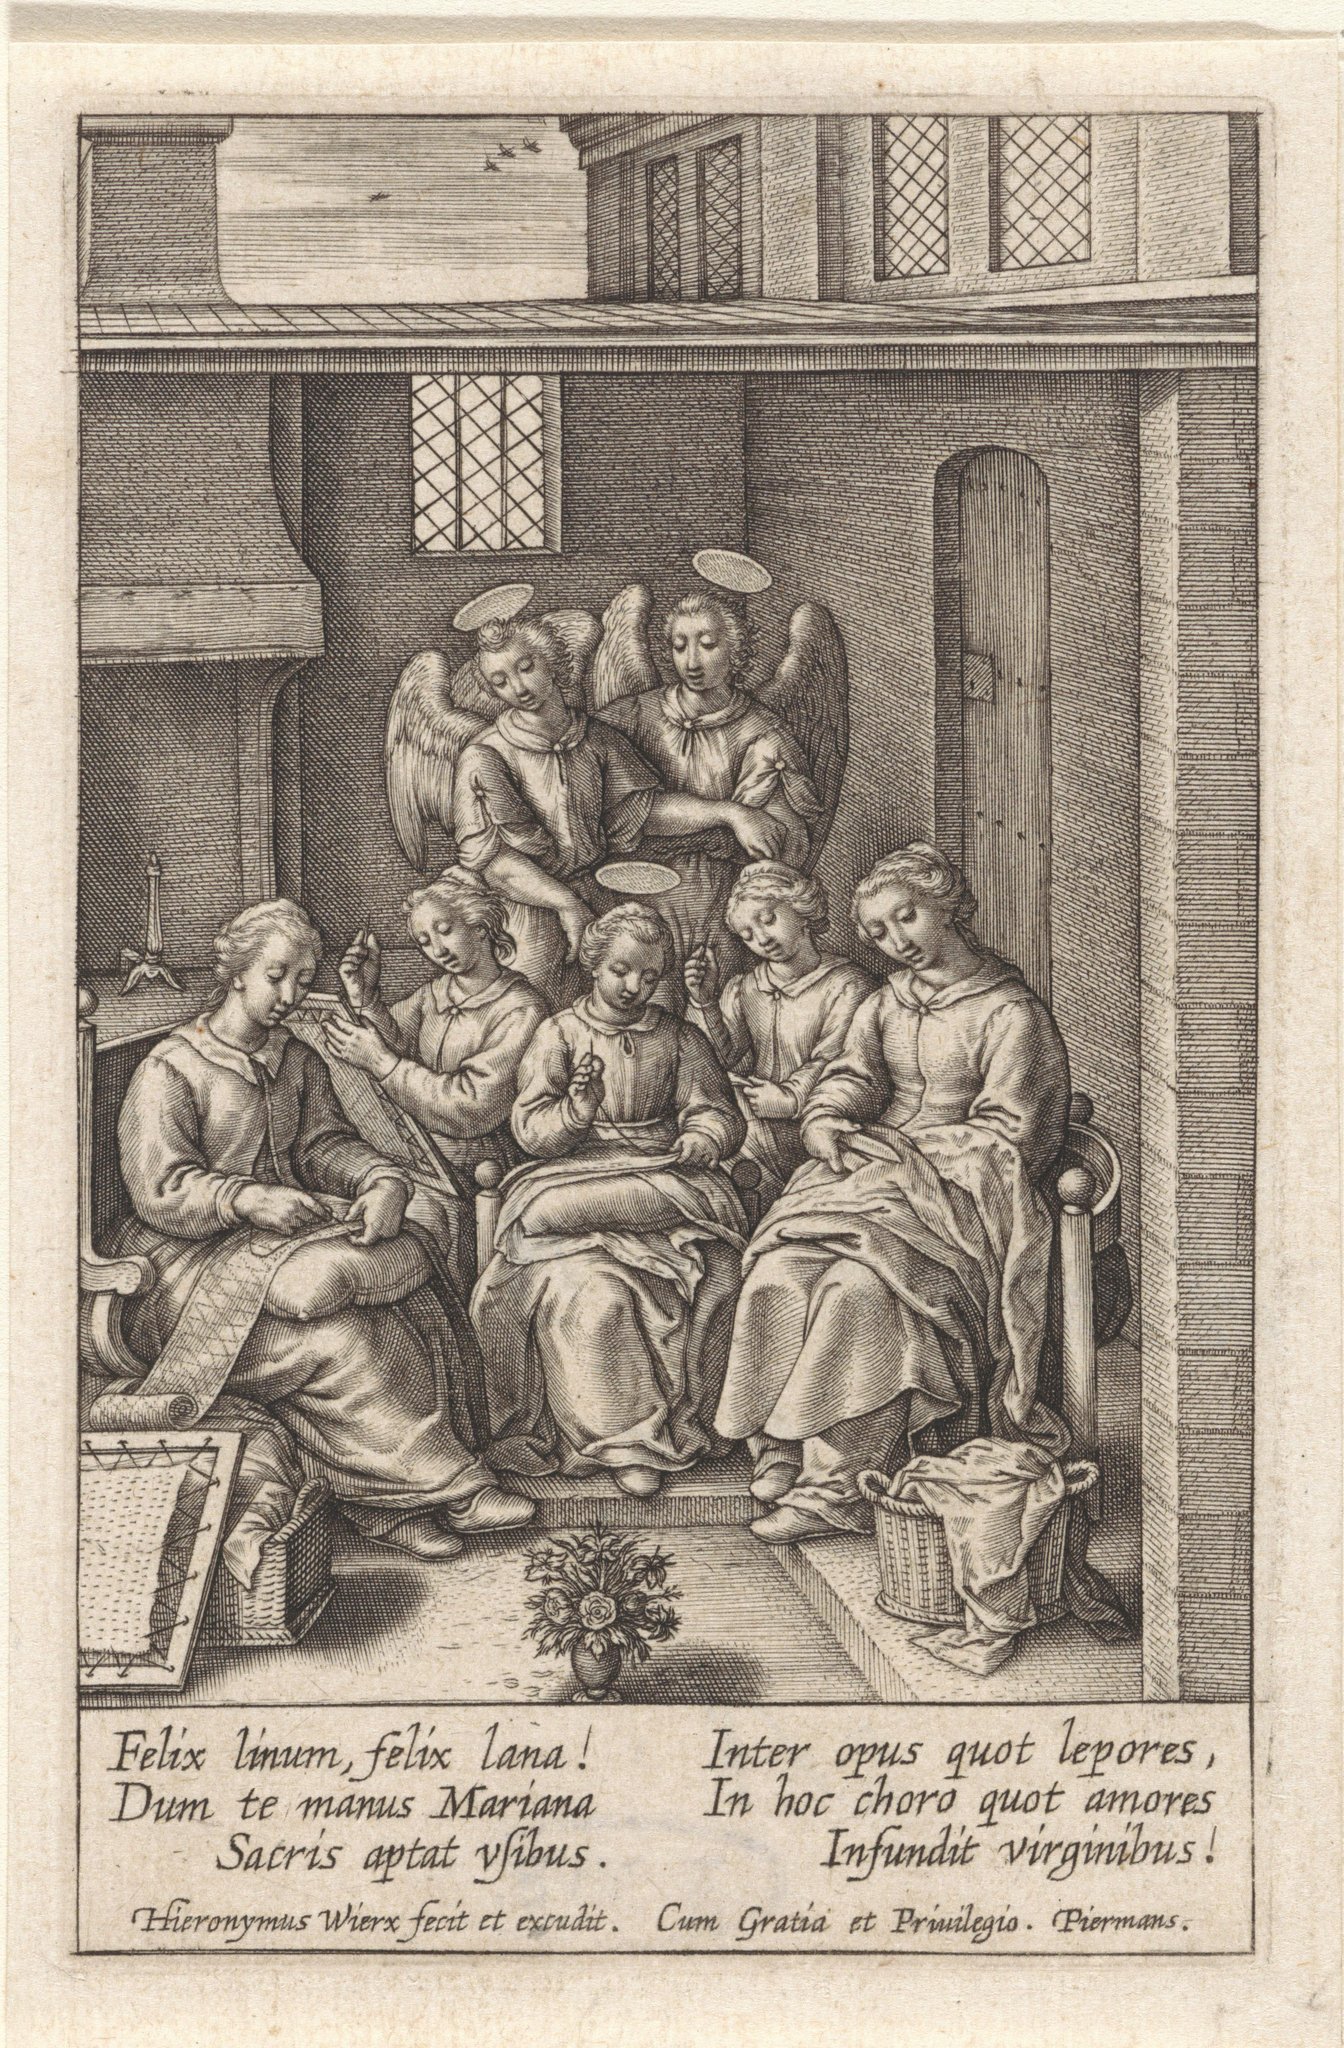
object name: print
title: Leven van de maagd Maria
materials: paper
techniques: engraving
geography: antwerp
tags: other scenes ~ education of mary (+ angel(s)), sewing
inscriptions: collector's mark: Lugt 2228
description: De jonge maagd Maria is aan het naaien, samen met vier andere jonge vrouwen. Achter haar staan twee engelen. In de marge een zesregelig onderschrift, in twee kolommen, in het Latijn.